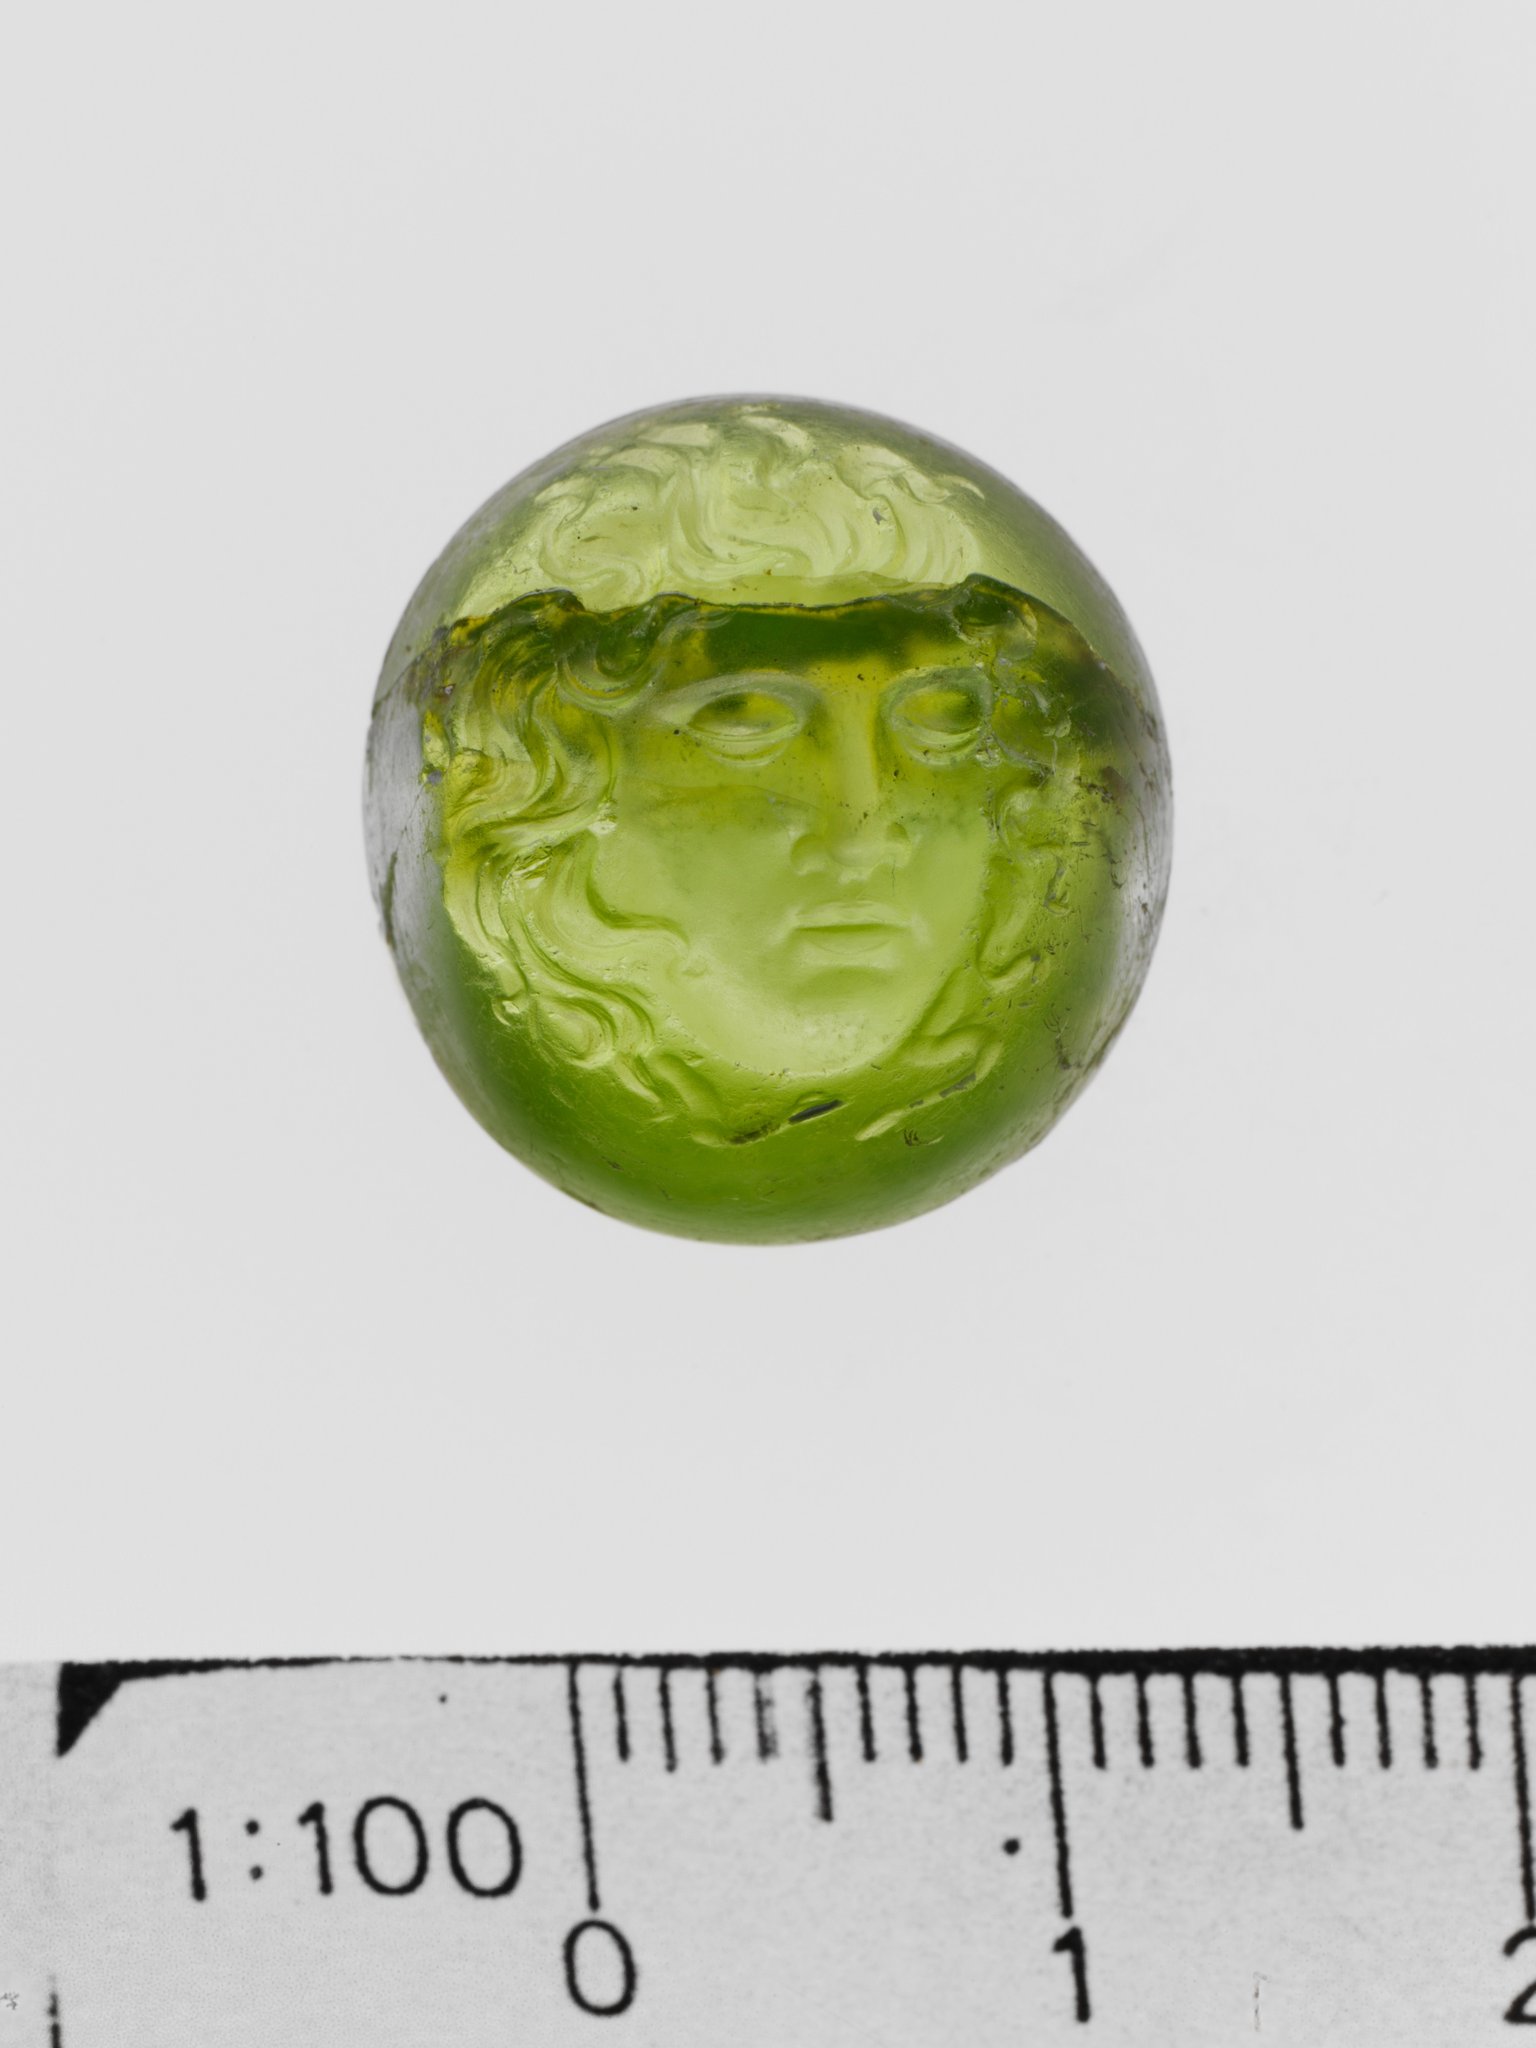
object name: intaglio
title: Peridot ring stone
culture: roman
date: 1-100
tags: heads,medusa